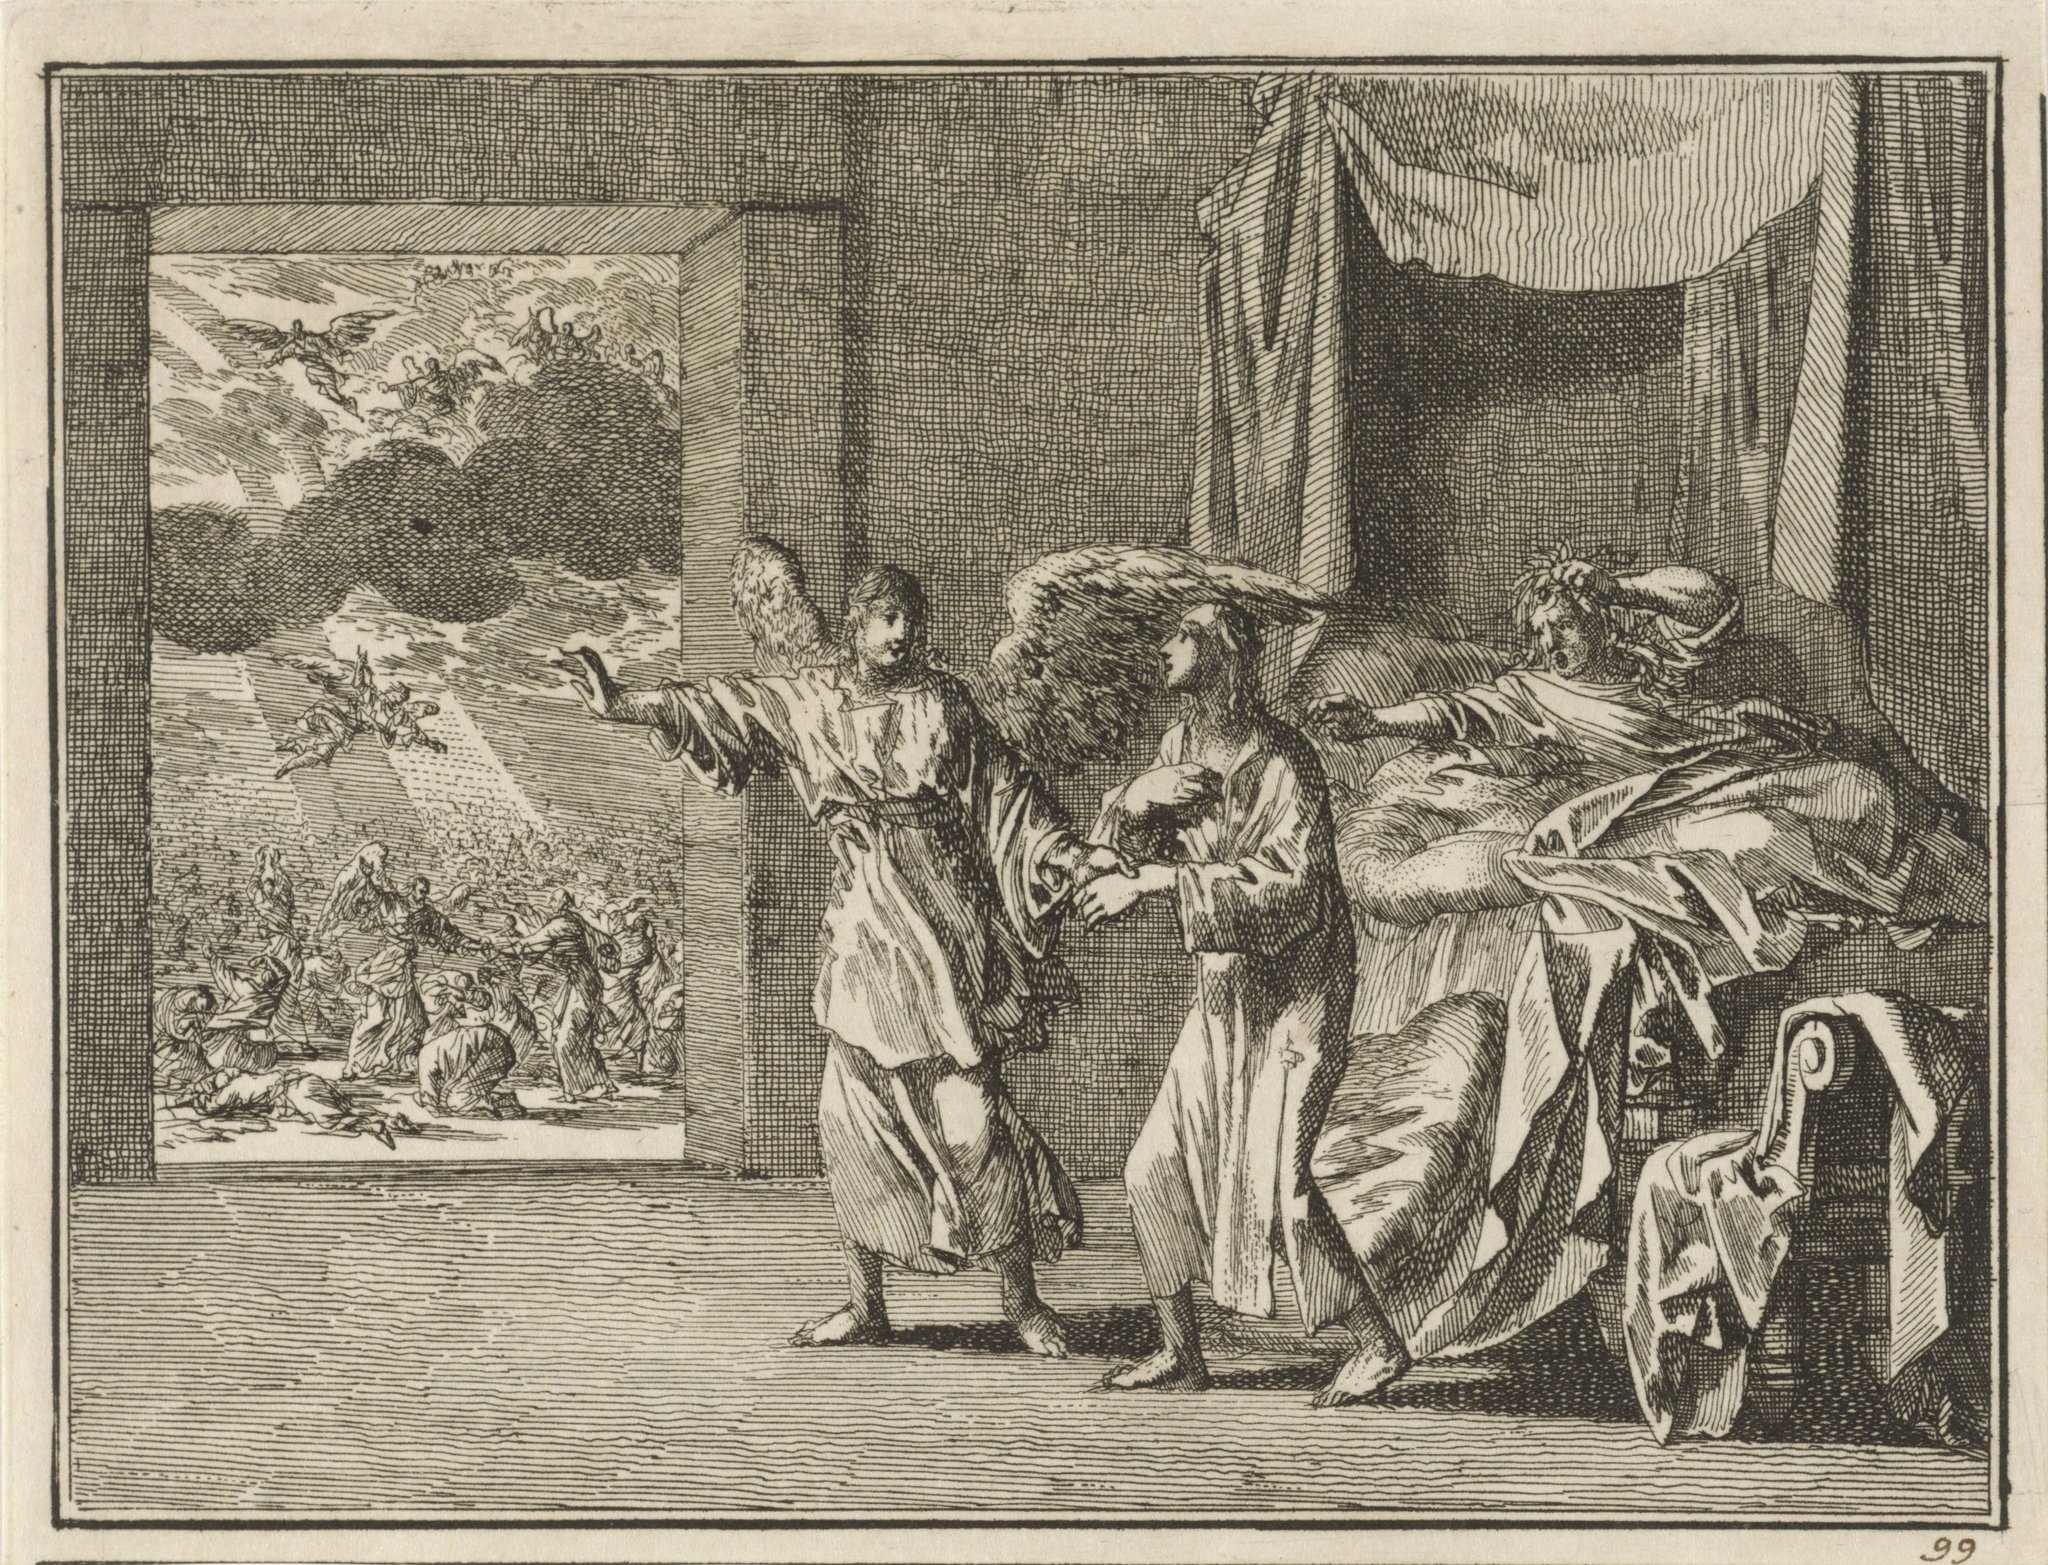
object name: print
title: Van twee op één bed liggende personen wordt één aangenomen en de ander verlaten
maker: jan luyken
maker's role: draughtsman, print maker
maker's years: 1649-1712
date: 1712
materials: paper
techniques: etching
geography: amsterdam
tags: sick-bed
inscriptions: number: ‘99’, collector's mark: Lugt 2228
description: Proefdruk van illustratie uit: Luyken, Jan. De schriftuurlyke geschiedenissen en gelykenissen van het Oude en Nieuwe Verbond, 2 delen. Amsterdam: Wed. Pieter Arentsz II en Cornelis van der Sys, 1712, dl. II.